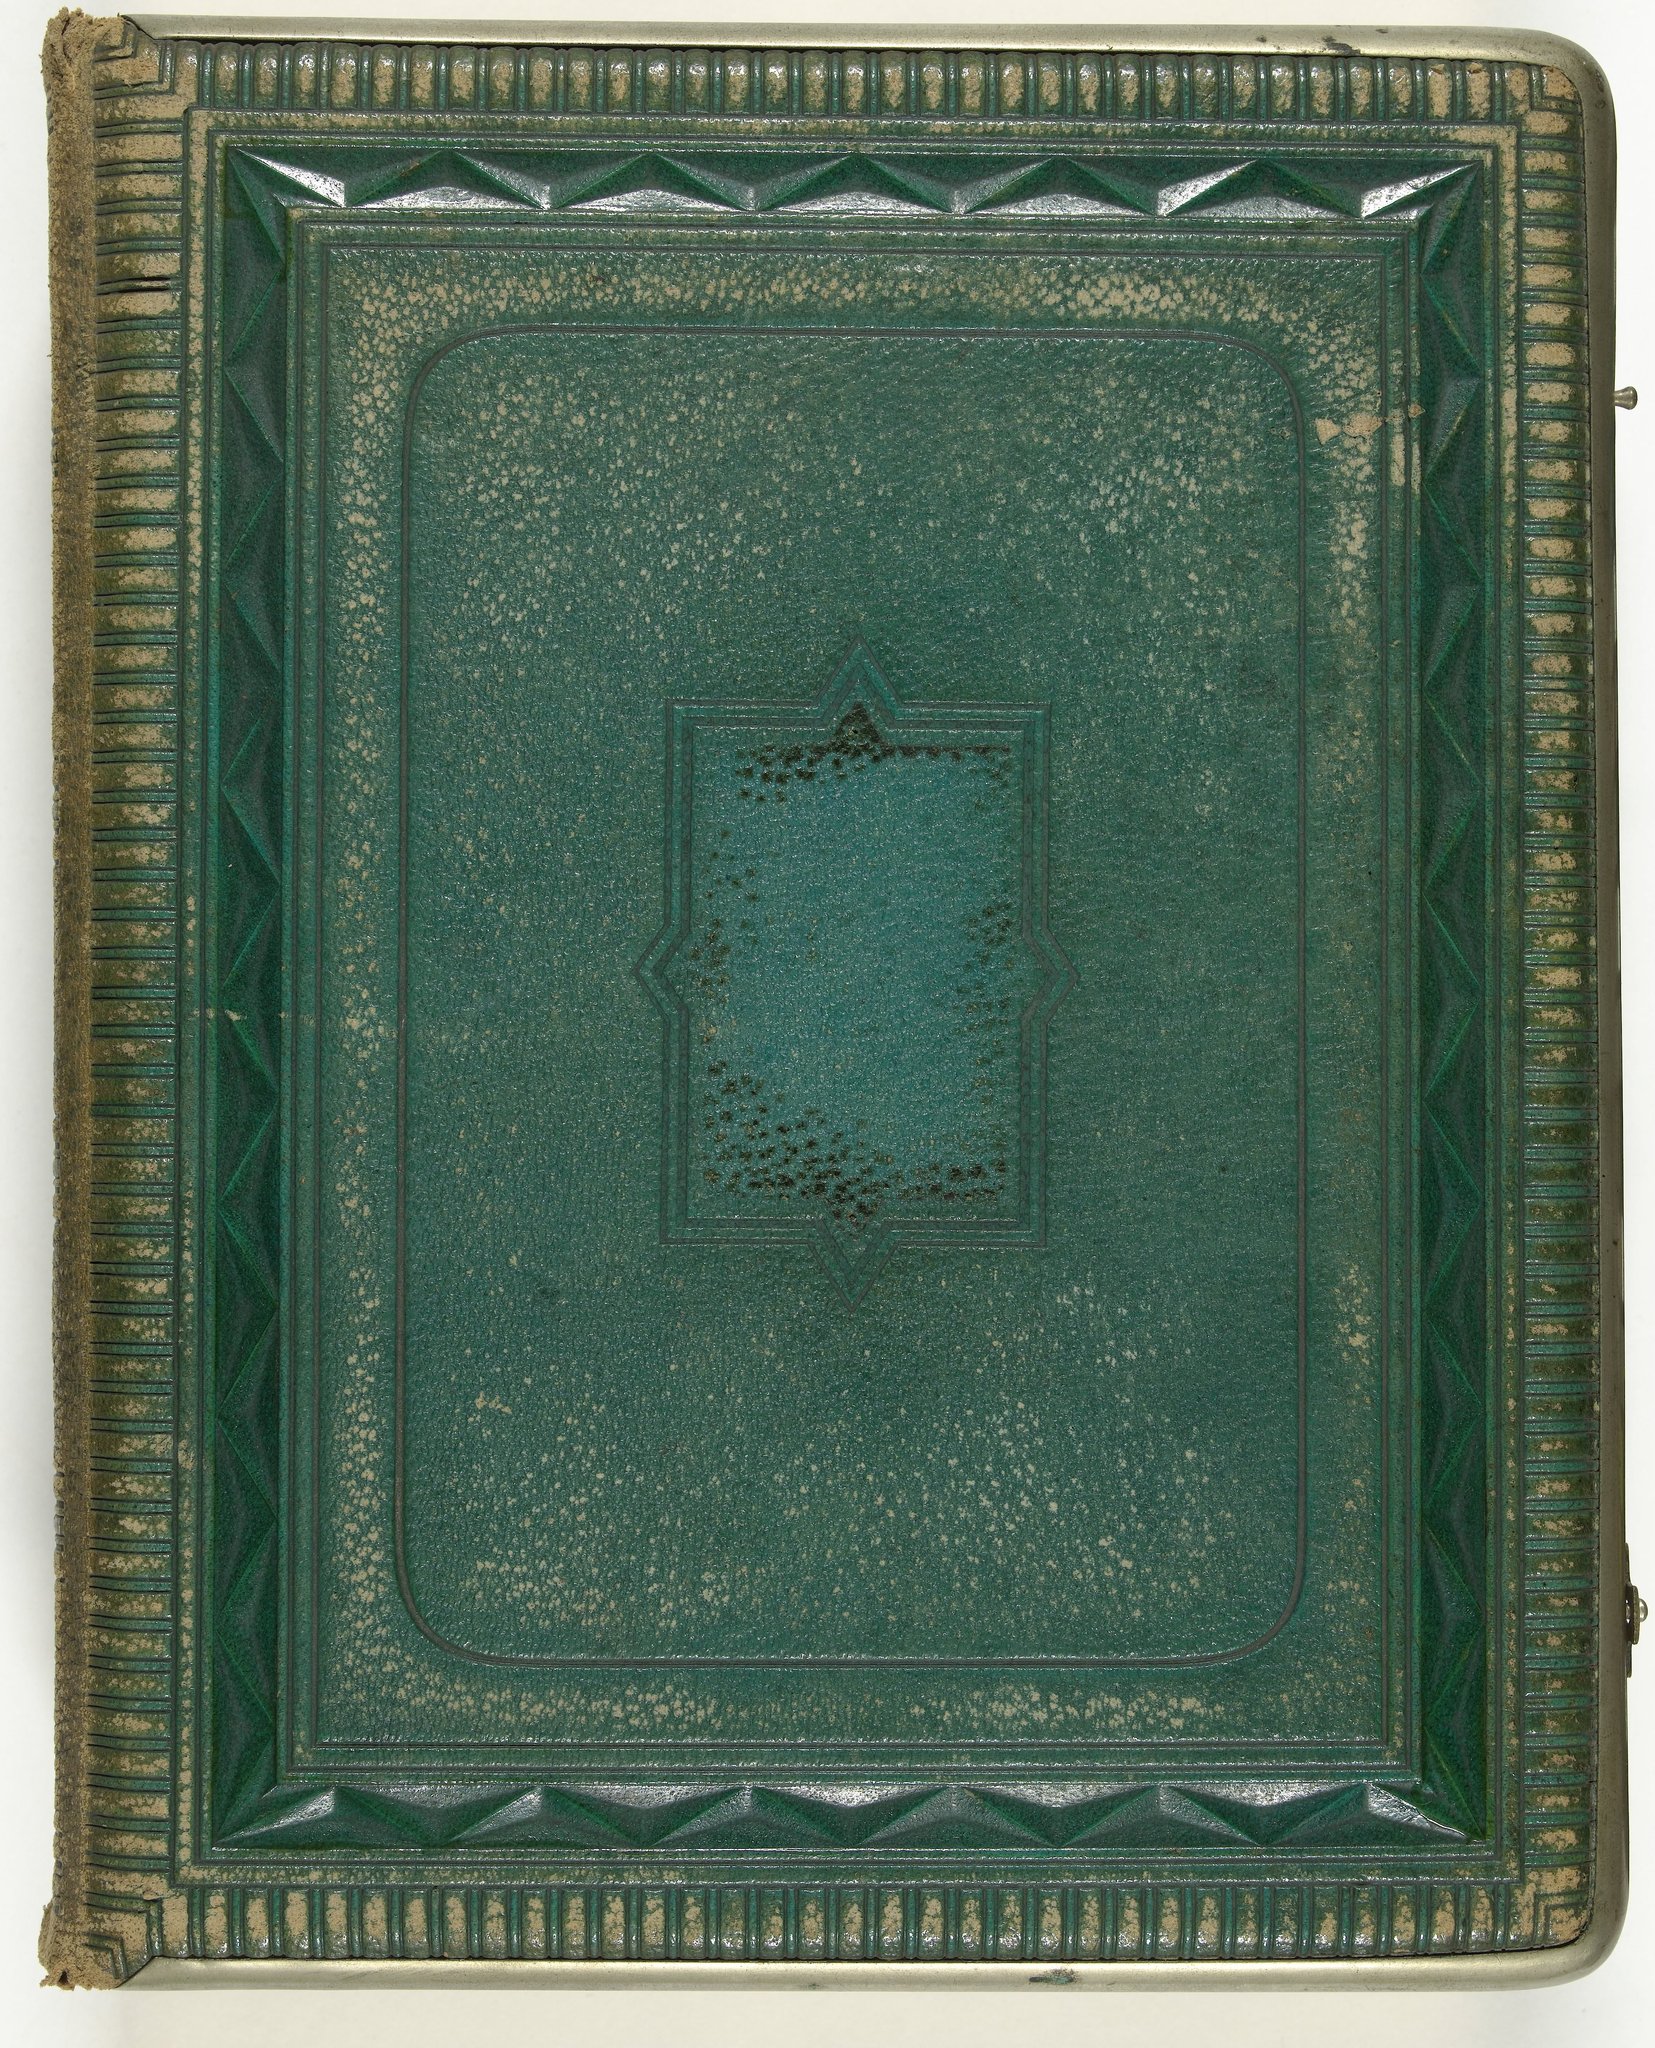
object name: photograph album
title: Nederlands familie-album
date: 1863-1865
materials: cardboard, leather, paper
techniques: photography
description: Familie-album Nederlands (vroeg) met 181 cartes-de-visite. Een donkergroen fotoalbum met passepartouts voor cartes de visite.